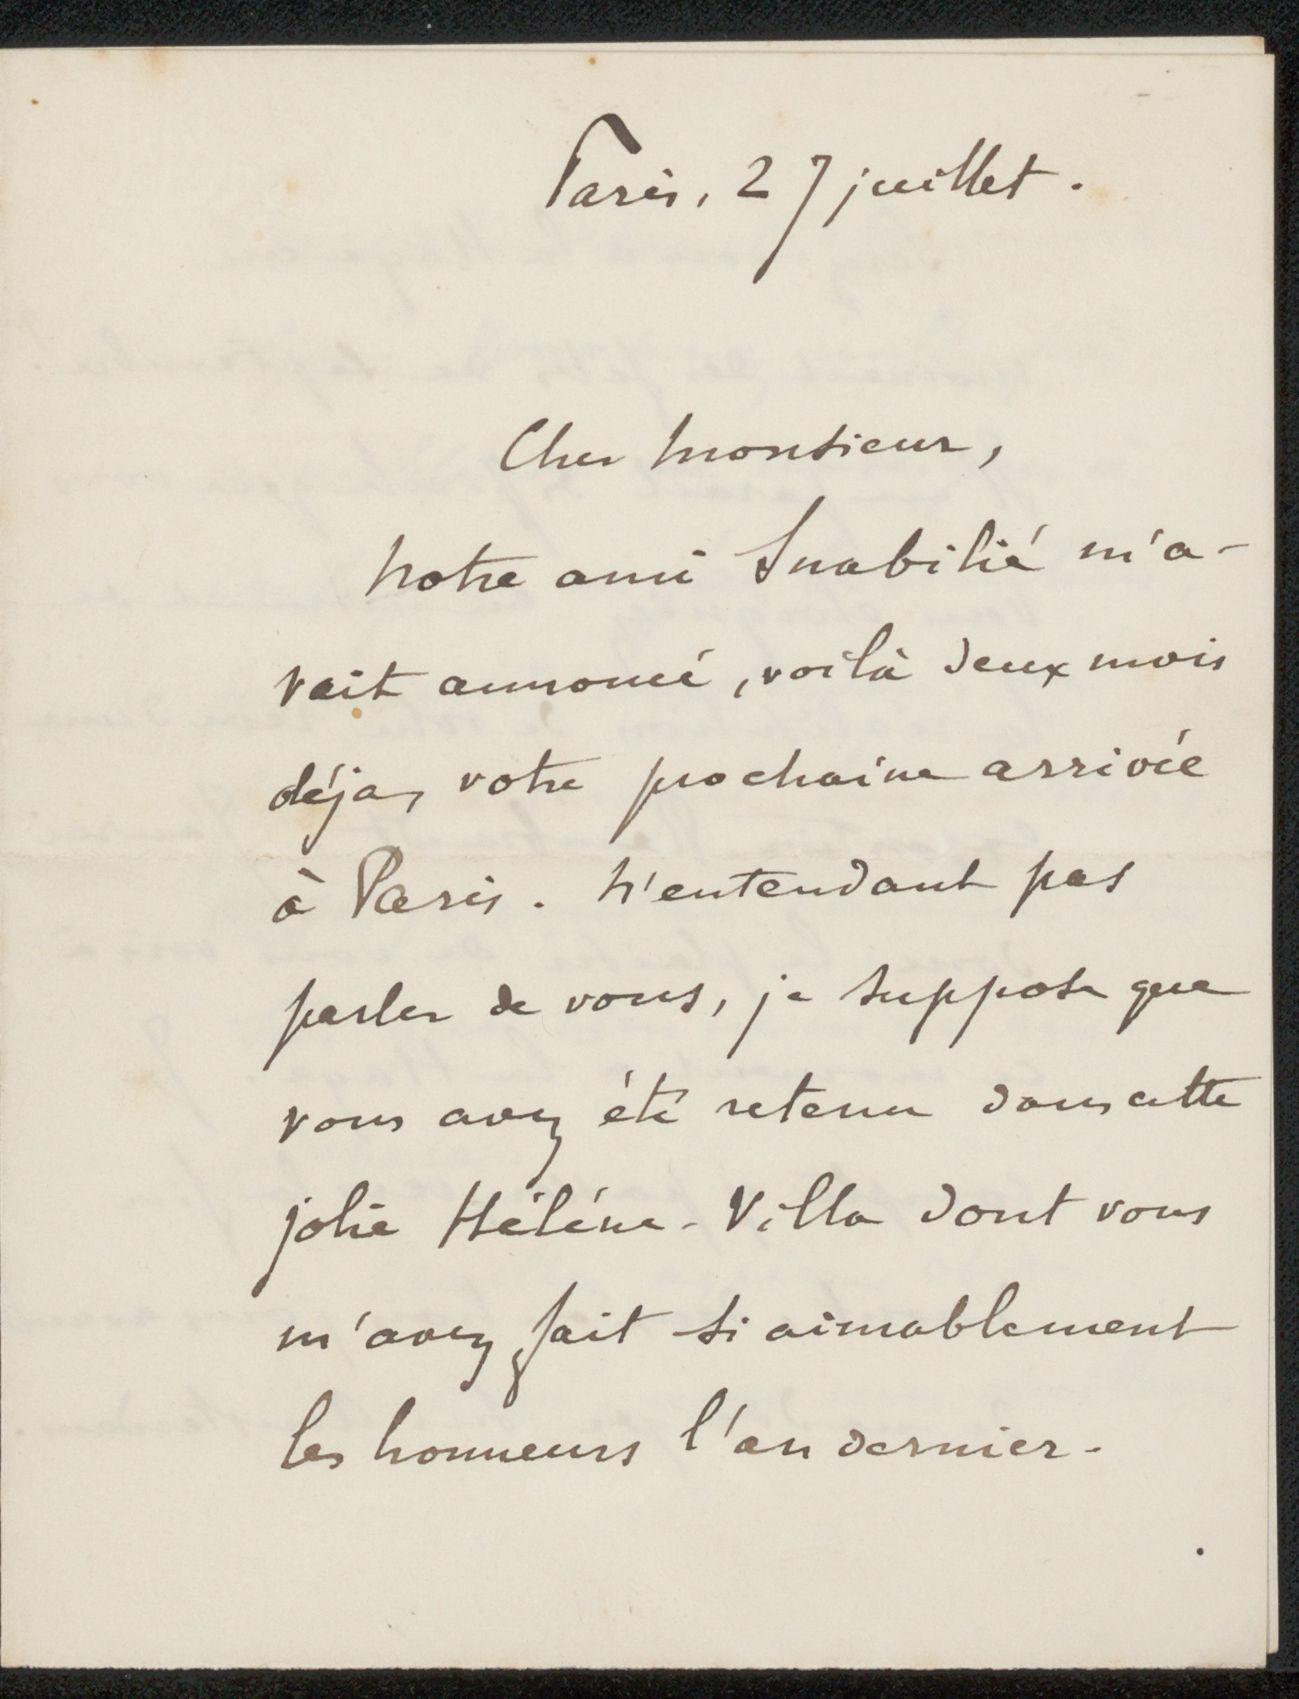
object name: letter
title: Brief aan Philip Zilcken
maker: françois thiébault-sisson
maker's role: kunstcriticus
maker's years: 1856-1944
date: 1898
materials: ink, paper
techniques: pen, writing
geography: paris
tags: leiden, amsterdam, painter, print maker, draughtsman, rembrandt van rijn, charles snabilié, the hague, philip zilcken, exhibition ~ art, paris, berlin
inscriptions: collector's mark: ‘RPK’, watermark